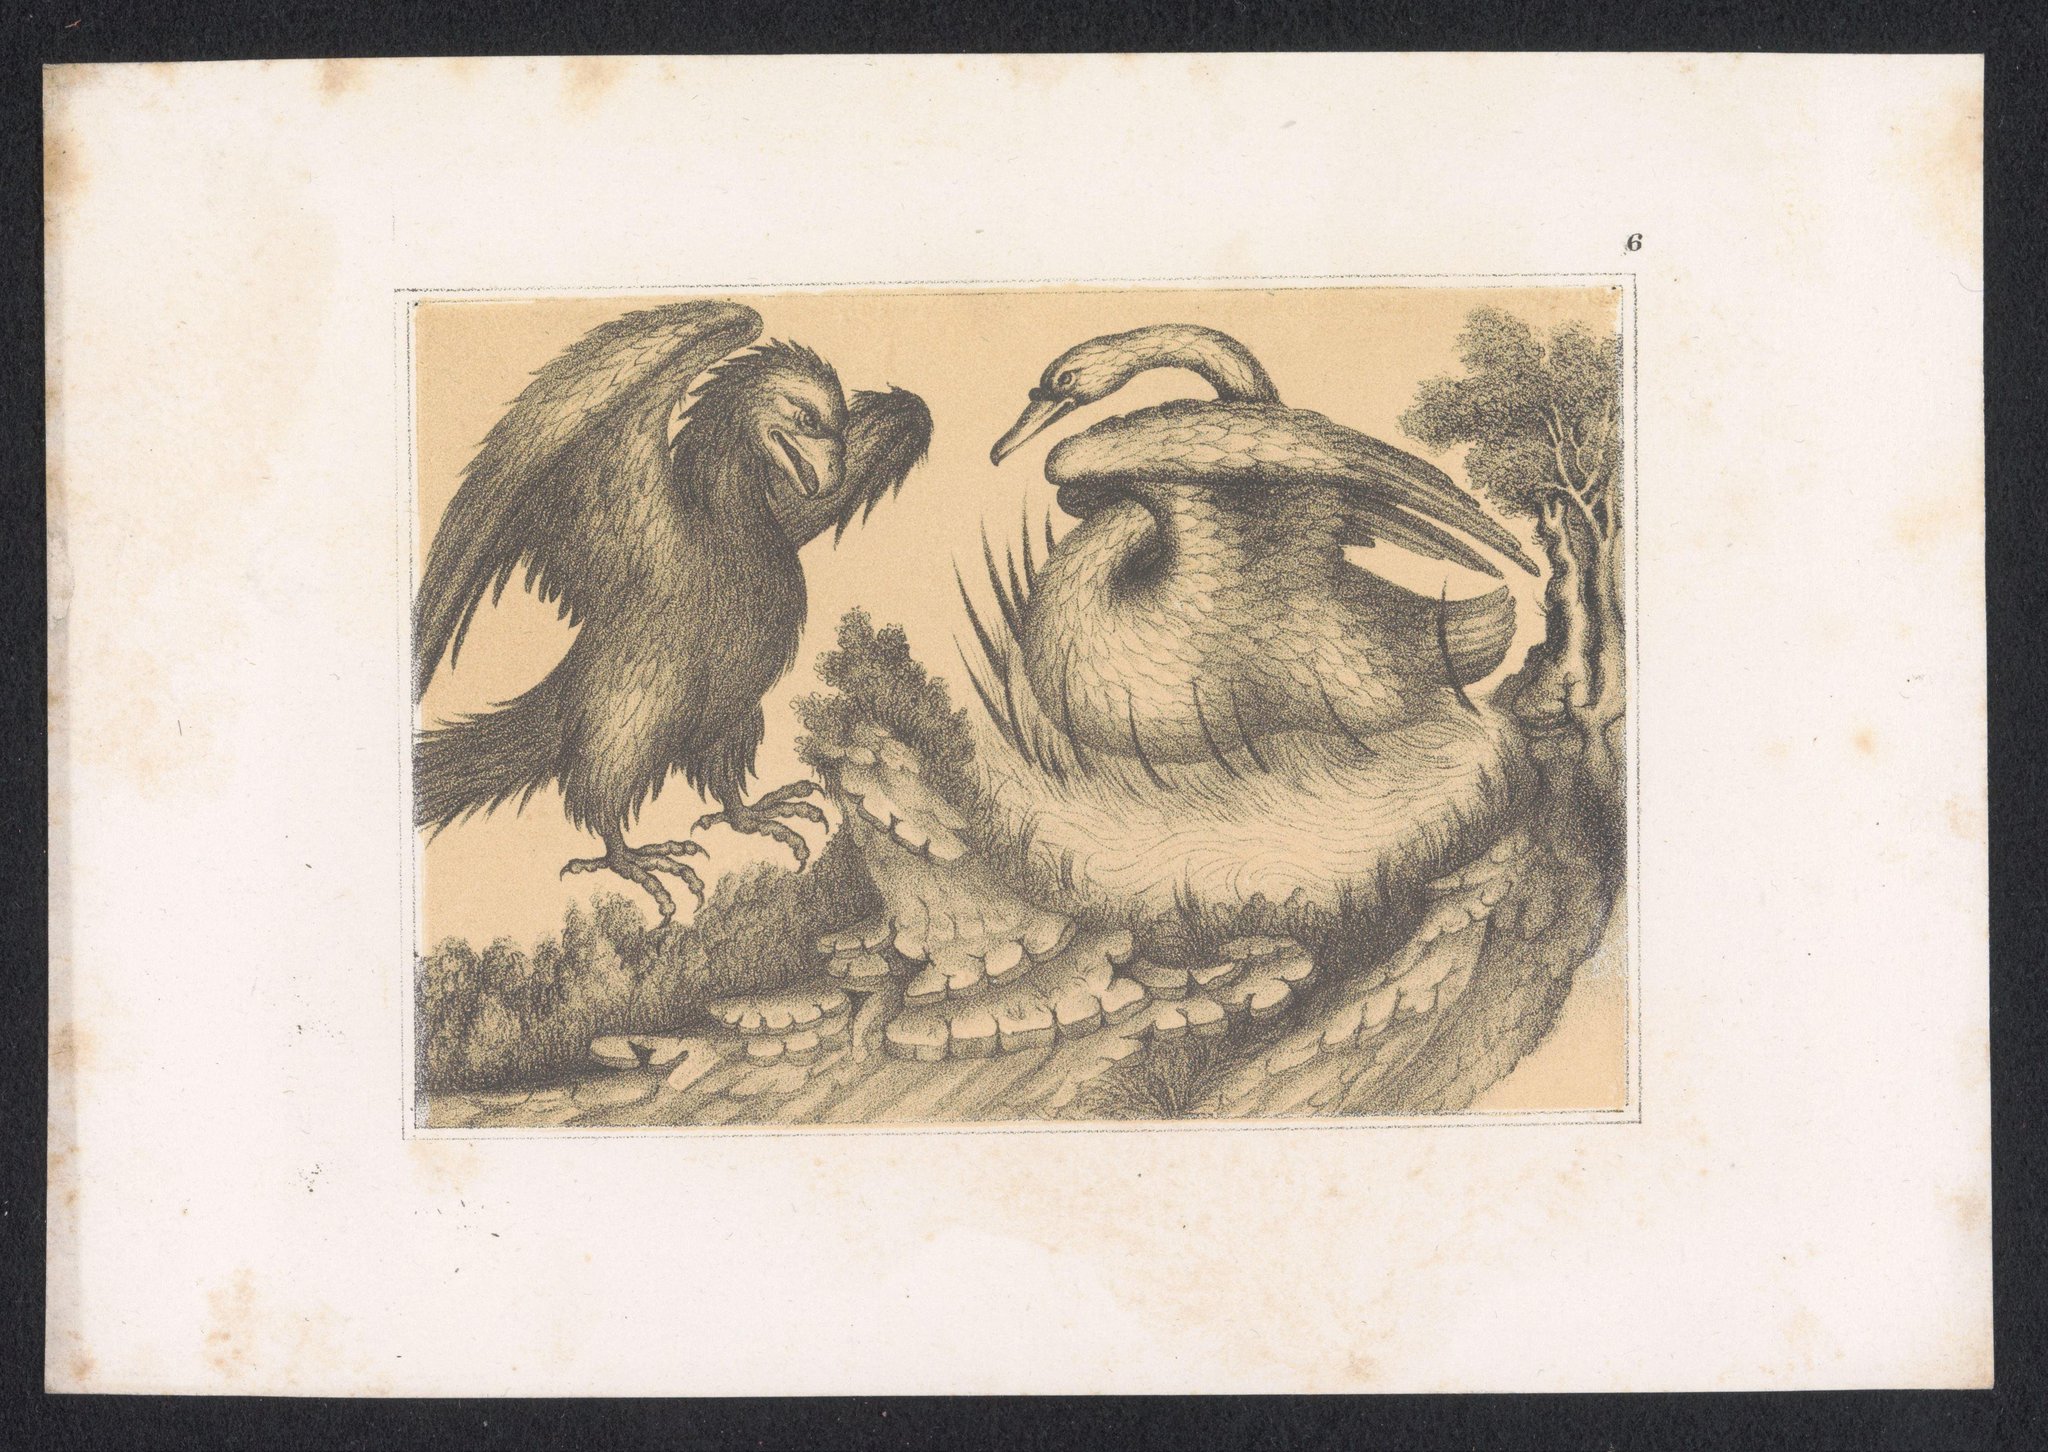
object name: print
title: Zwaan en adelaar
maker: karl palzow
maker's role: print maker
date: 1830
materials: paper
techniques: tone lithography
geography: berlin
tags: predatory birds: eagle, water-birds: swan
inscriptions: collector's mark: Lugt 2228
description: Een zwaan zittend op zijn nest staat dreigend tegenover een adelaar. Prent is onderdeel van een omslag met tekst en een serie van achttien lithografieën naar schilderijen van Nederlandse meesters.